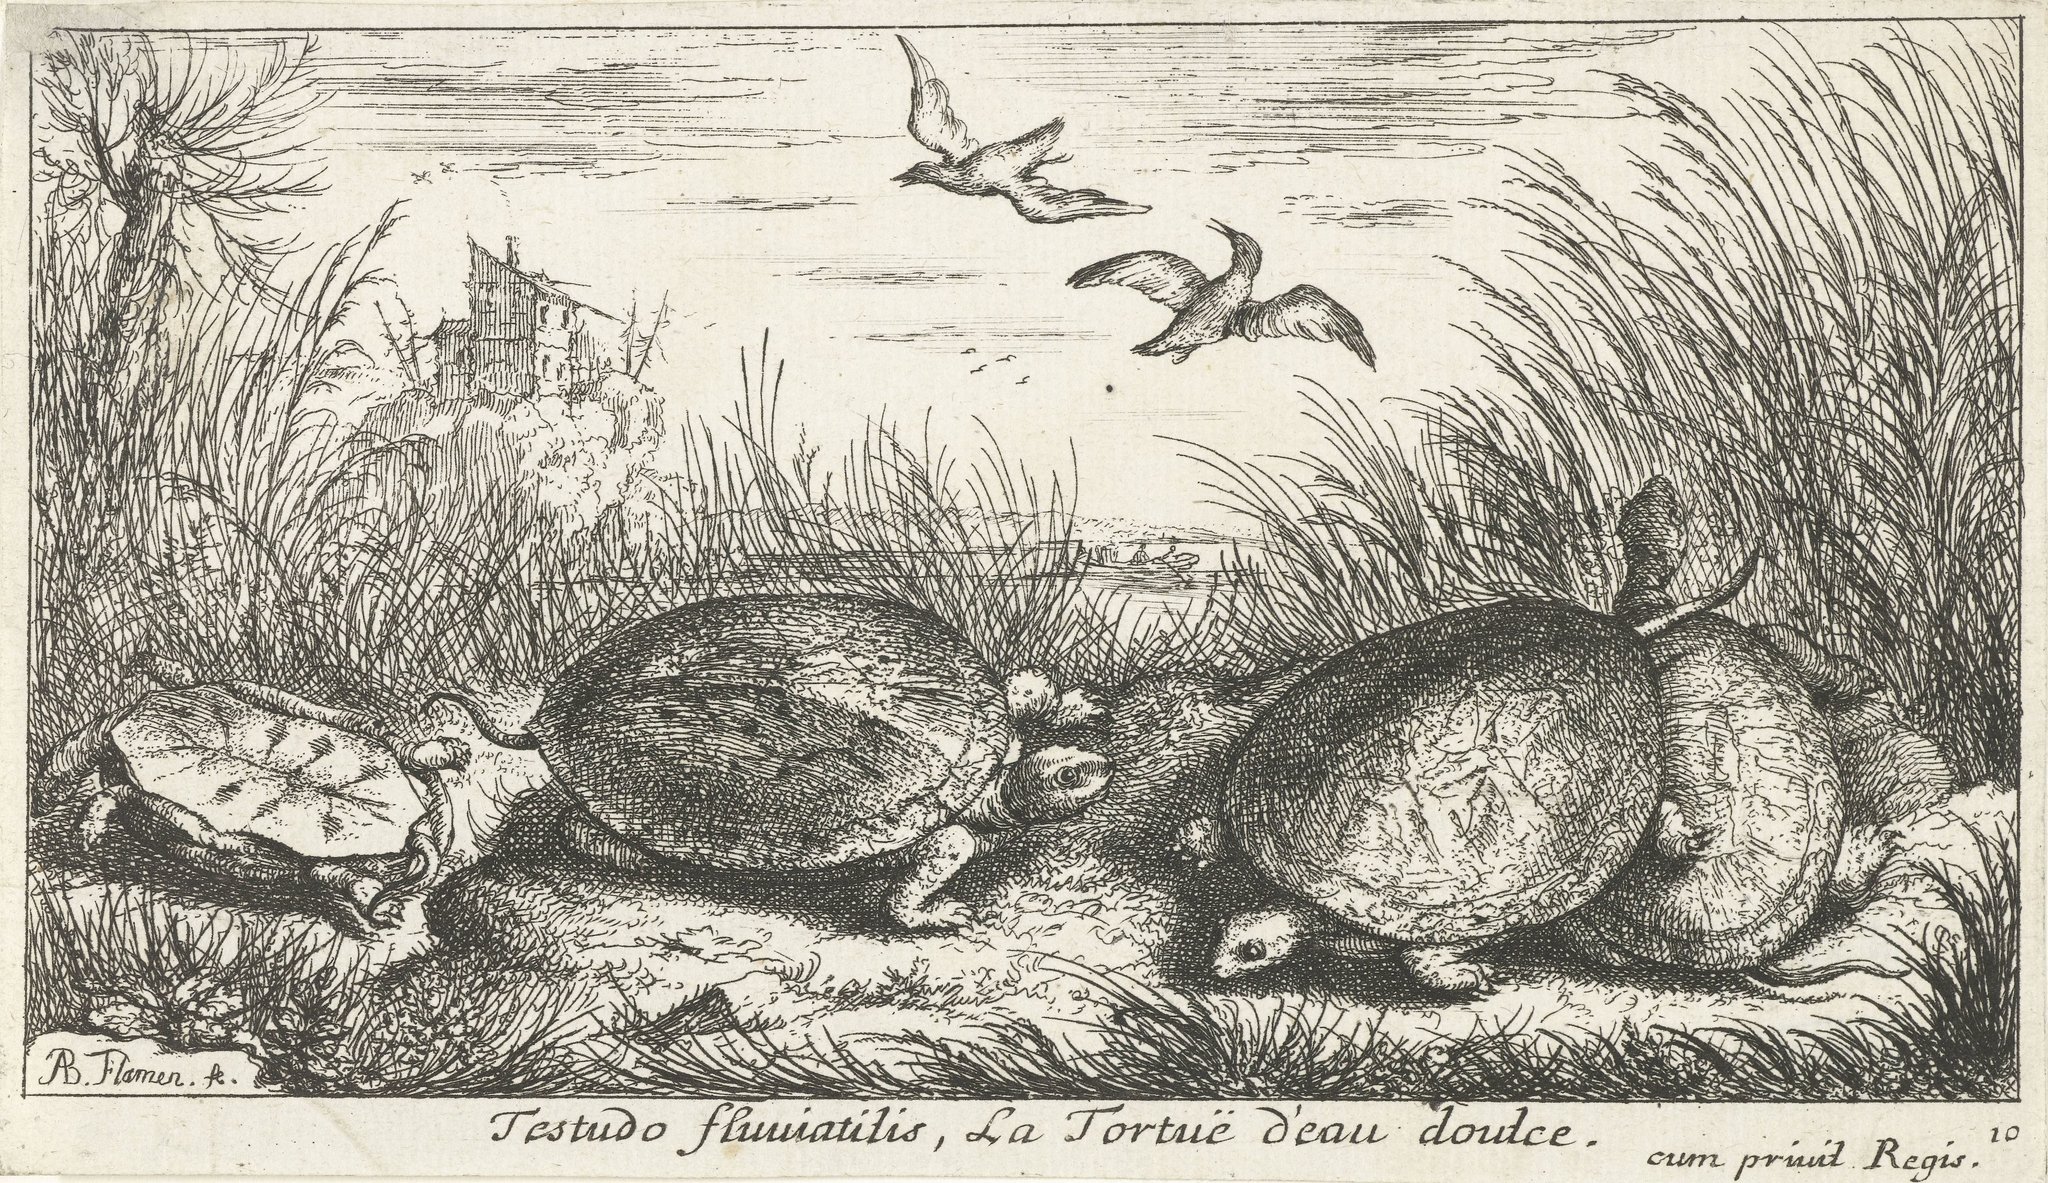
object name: print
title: Testudo fluuiatilis, La Tortuë d'eau doulce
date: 1664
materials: paper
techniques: etching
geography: paris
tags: tortoises, turtles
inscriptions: collector's mark: Lugt 2228